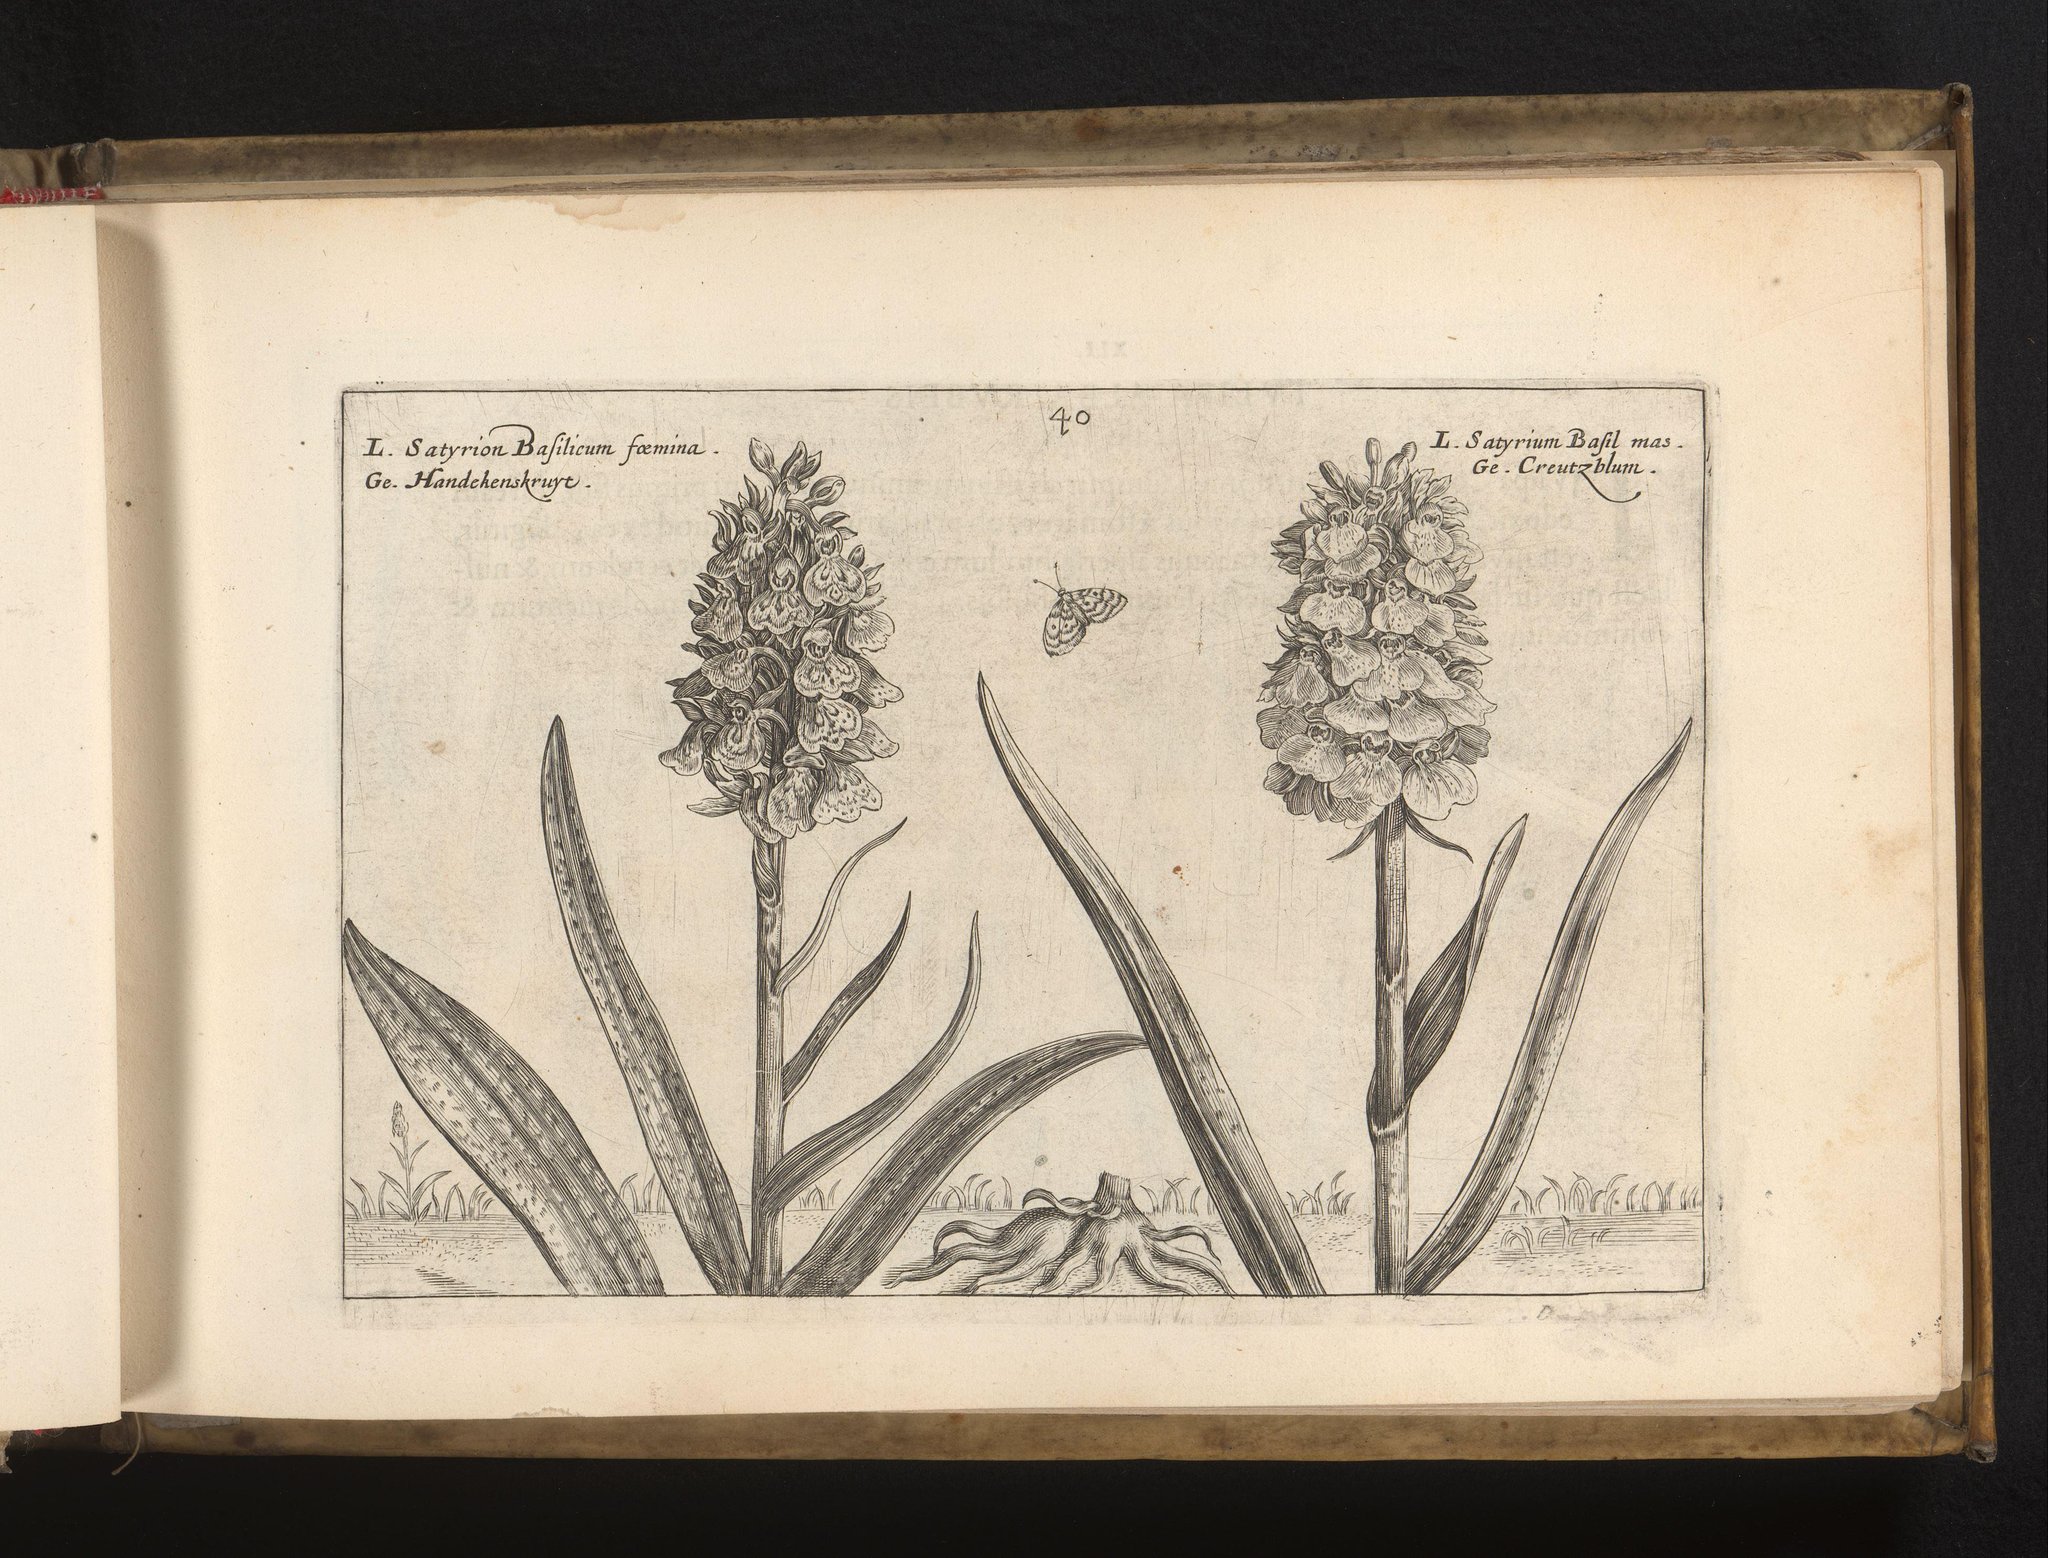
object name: page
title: Bloementuin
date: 1617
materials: paper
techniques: engraving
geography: utrecht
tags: flowers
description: Prent uit: Passe, Crispijn van de (II). Hortus floridus in quo rariorum & minus vulgarium florum icones ad vivam veramque formam. Arnhem: Johannes Janssonius, 1617.